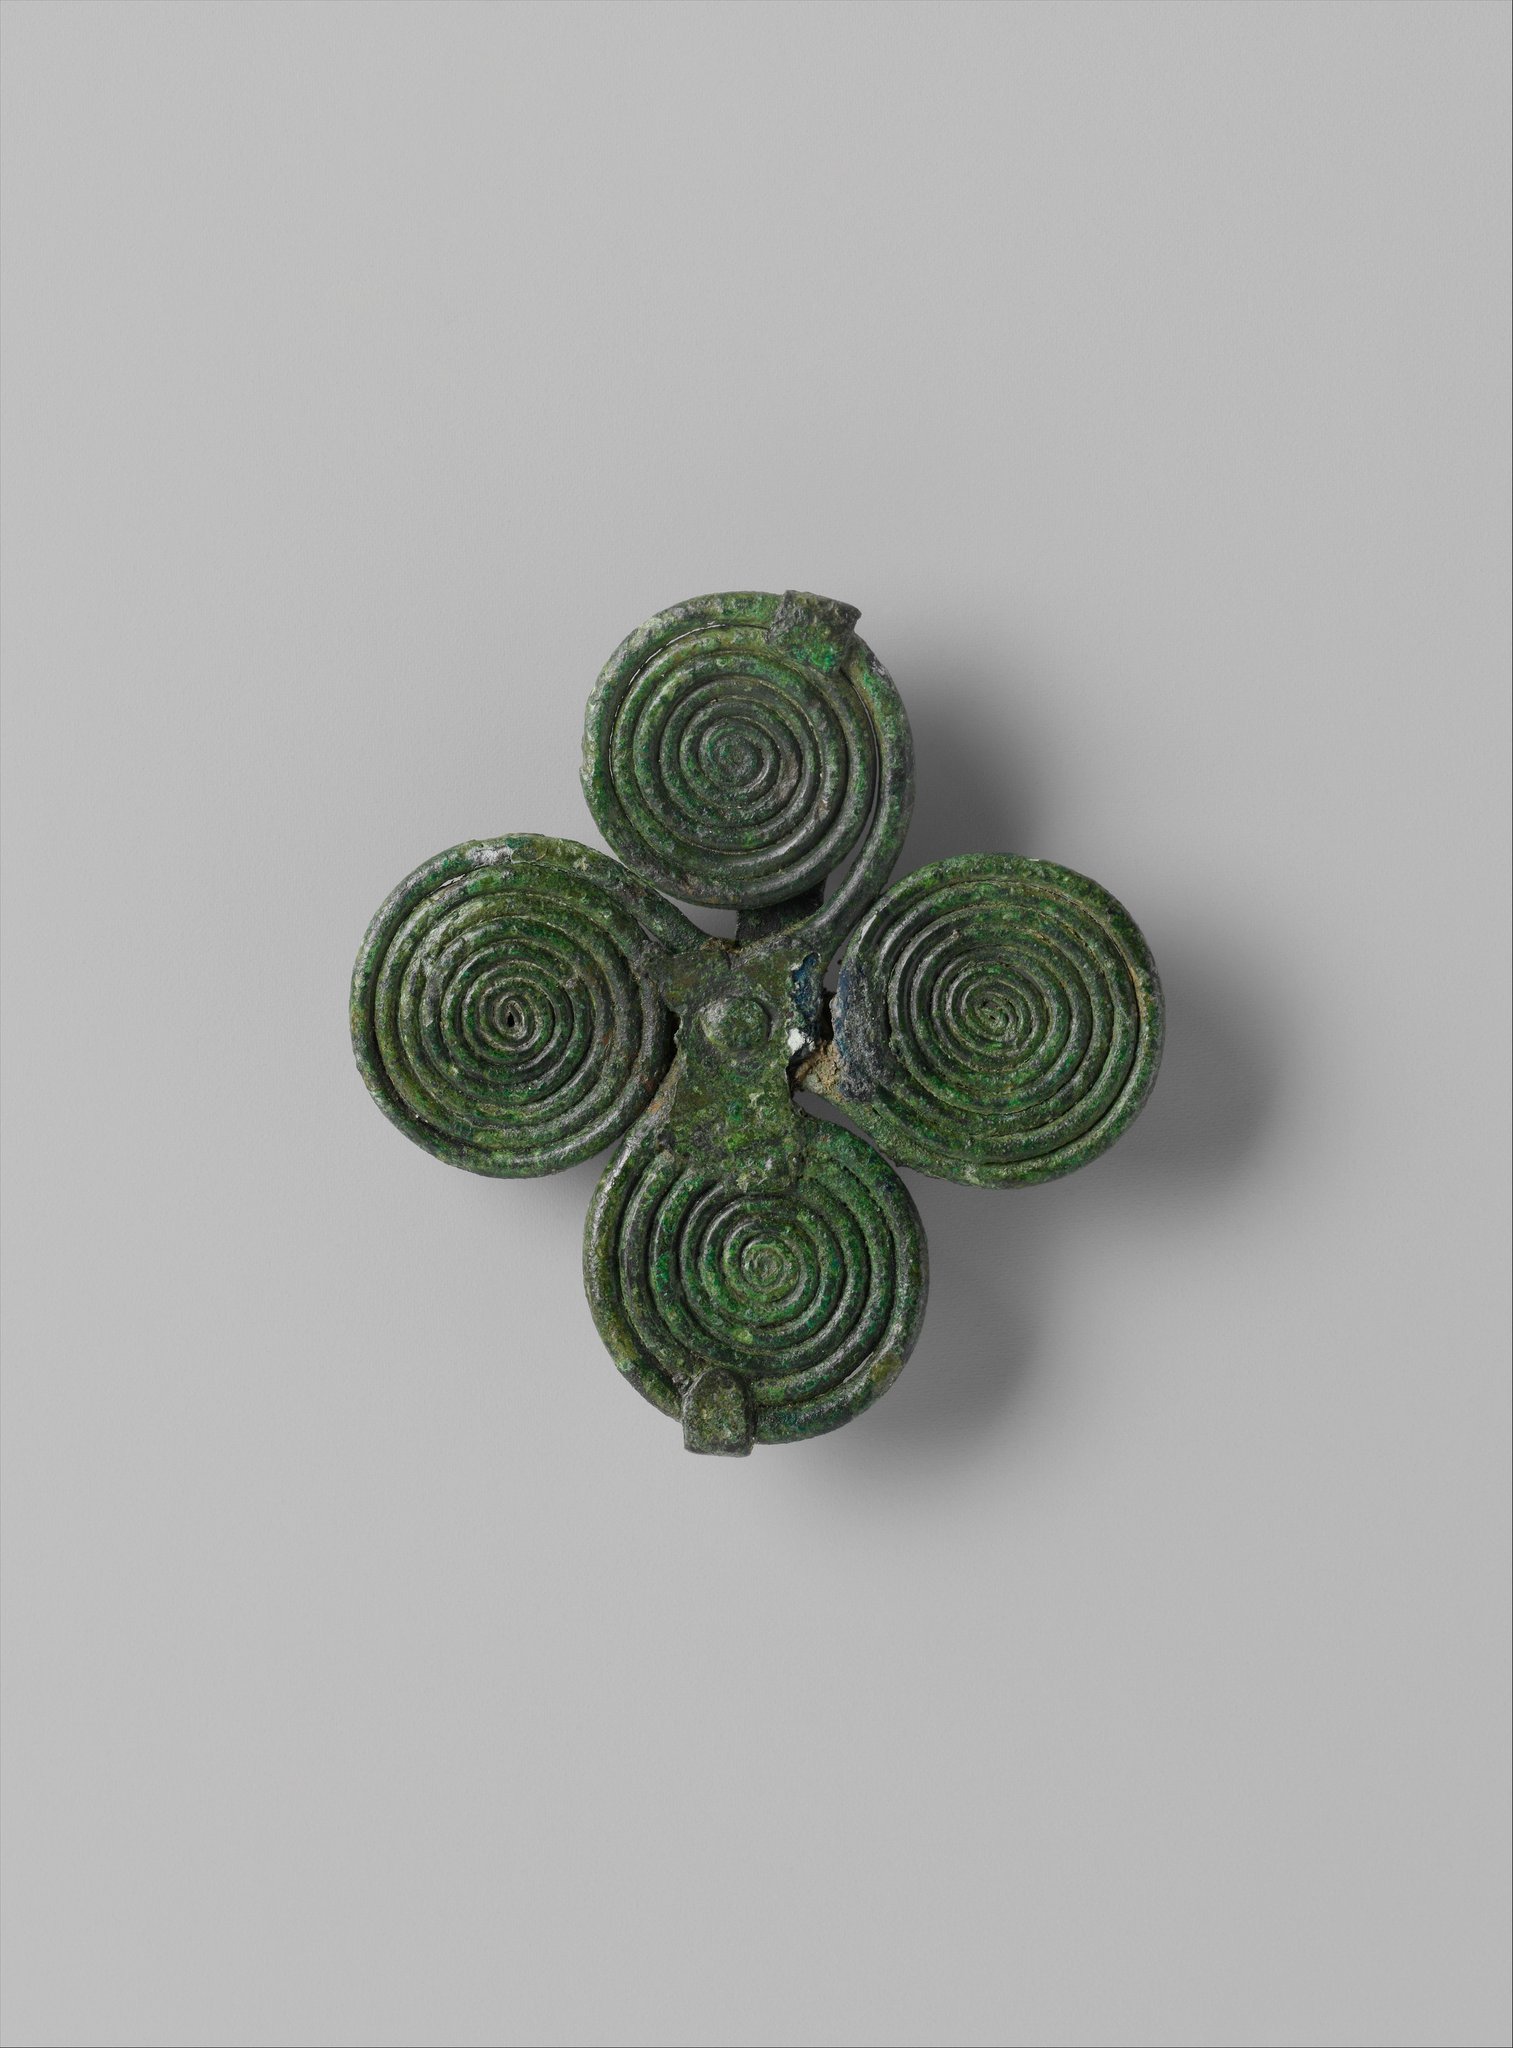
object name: brooch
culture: european bronze age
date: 800-701 BCE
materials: copper alloy